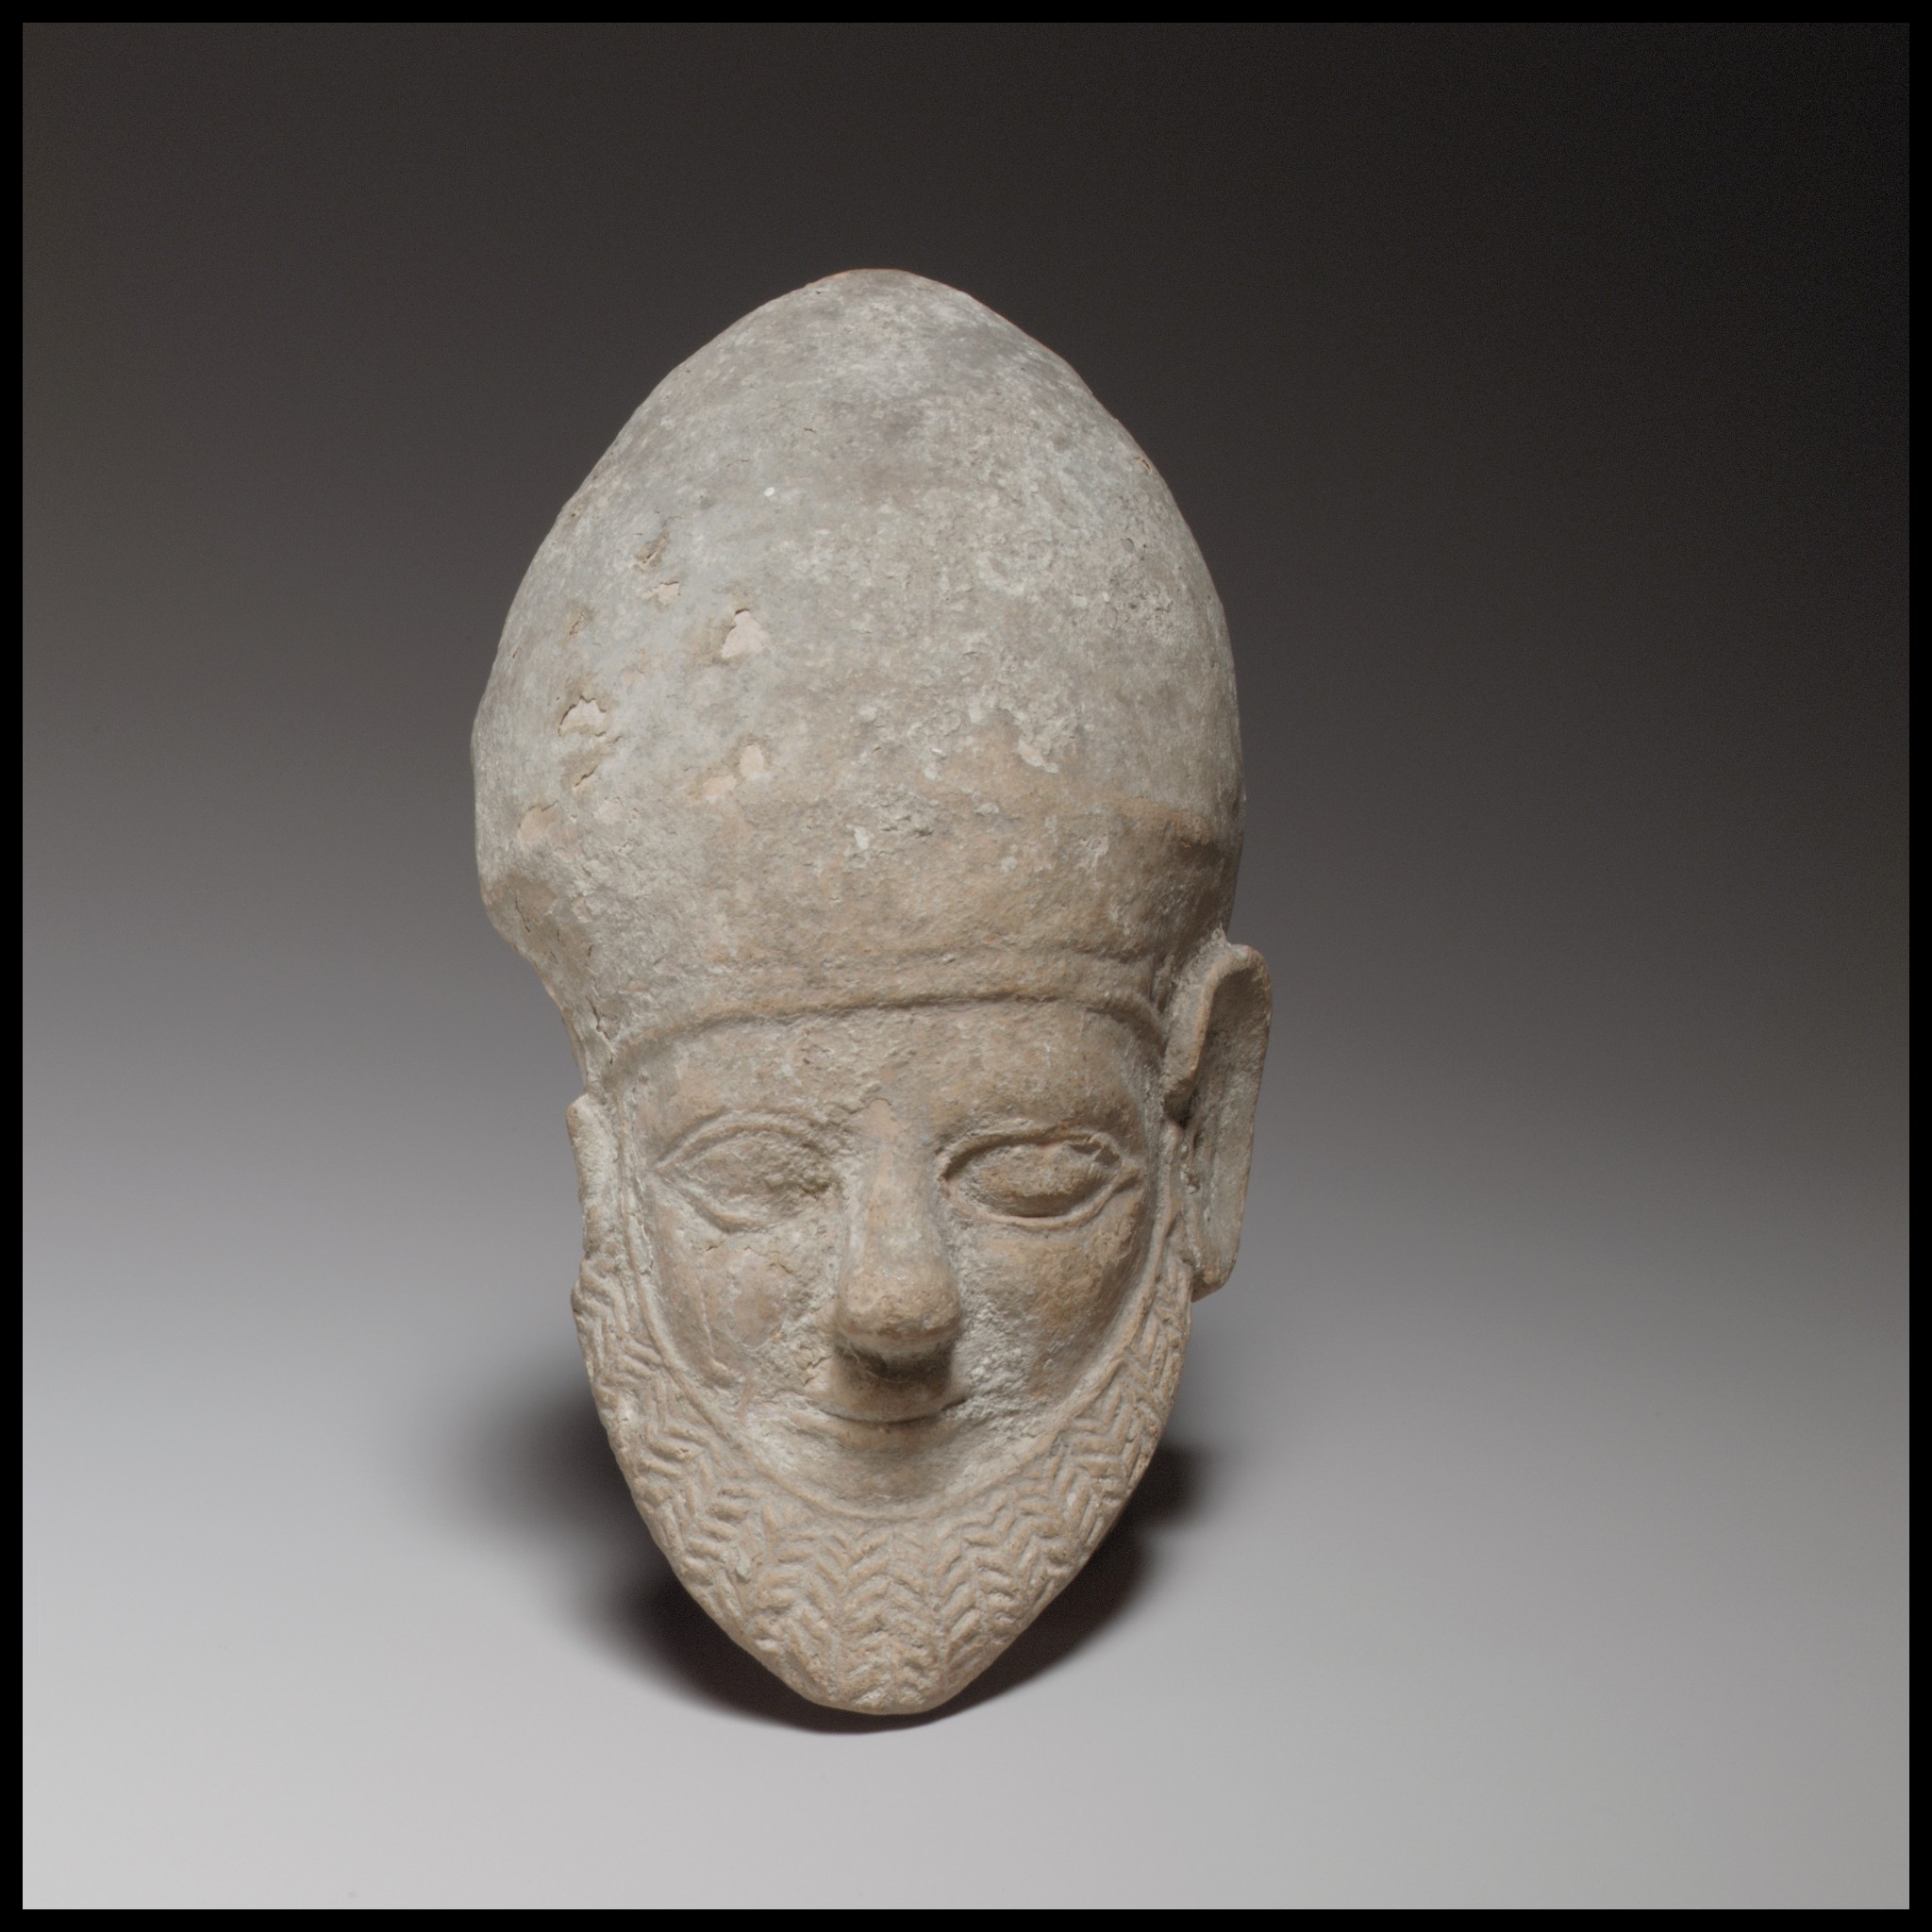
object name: head of a male votary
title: Bearded male head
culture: cypriot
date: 600-568 BCE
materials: terracotta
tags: helmets,heads,men